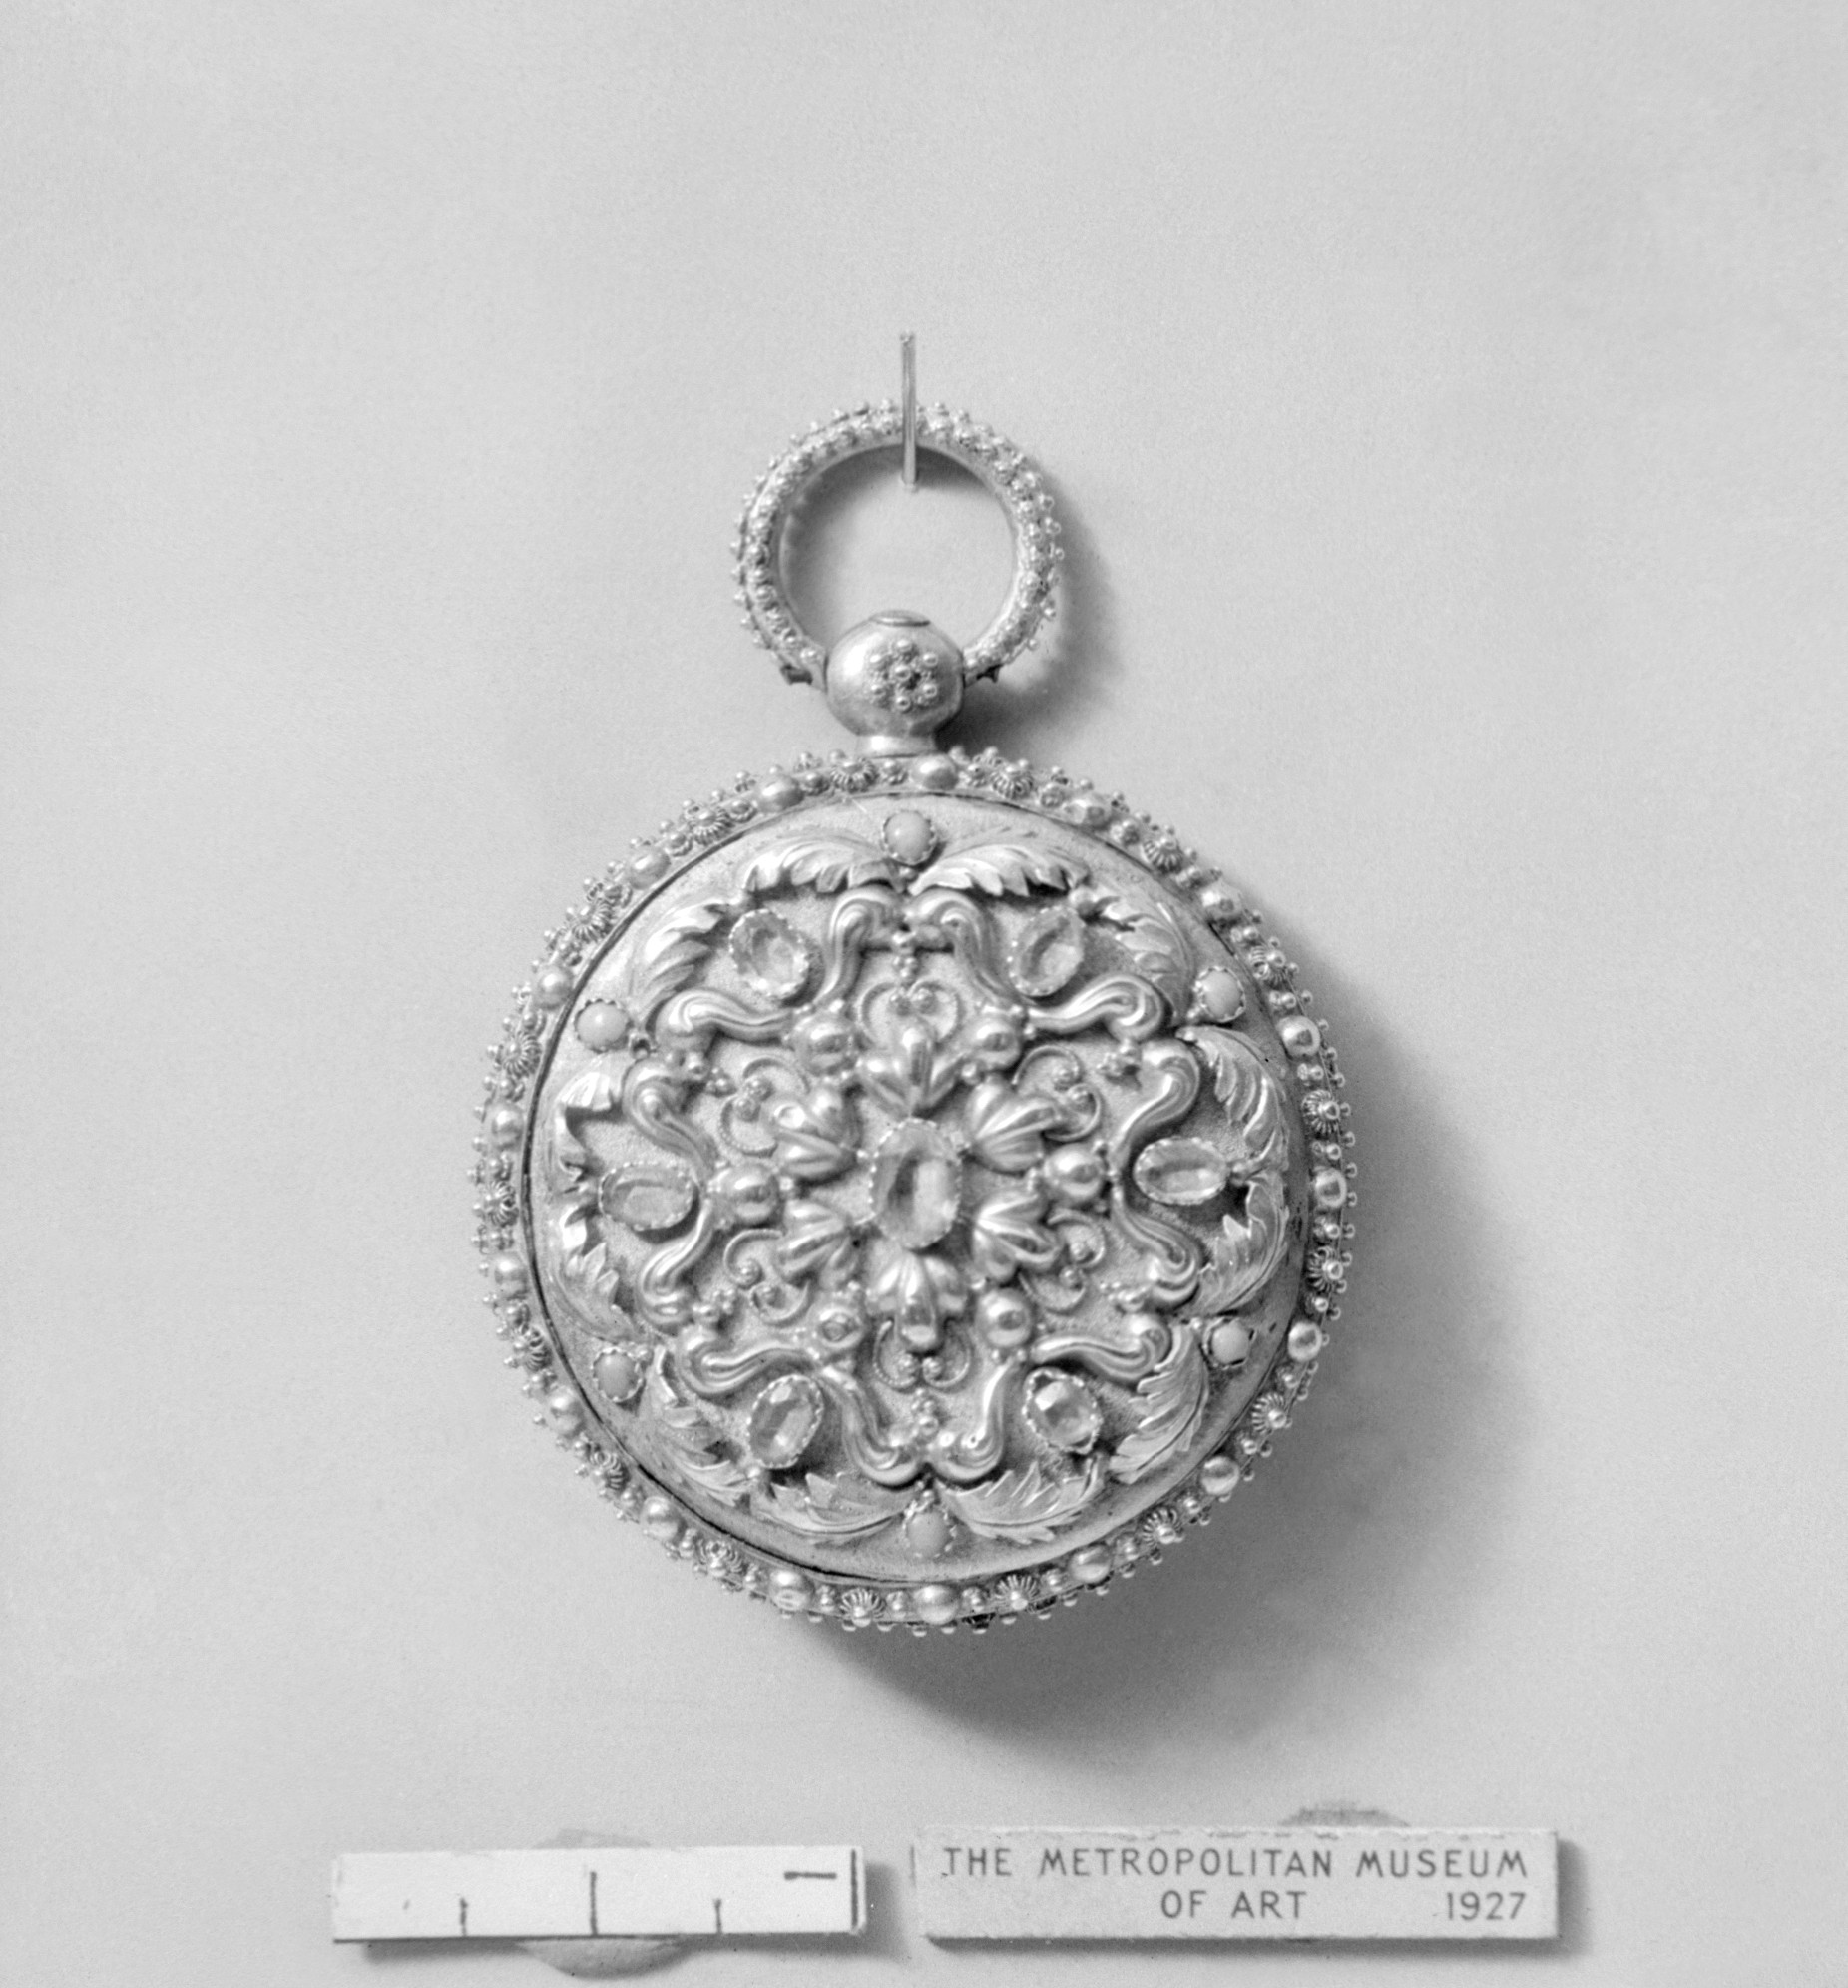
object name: watch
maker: firm of louis duchène et fils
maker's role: maker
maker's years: 1790-1820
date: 1815-1830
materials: gold, silver, steel, stone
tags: leaves